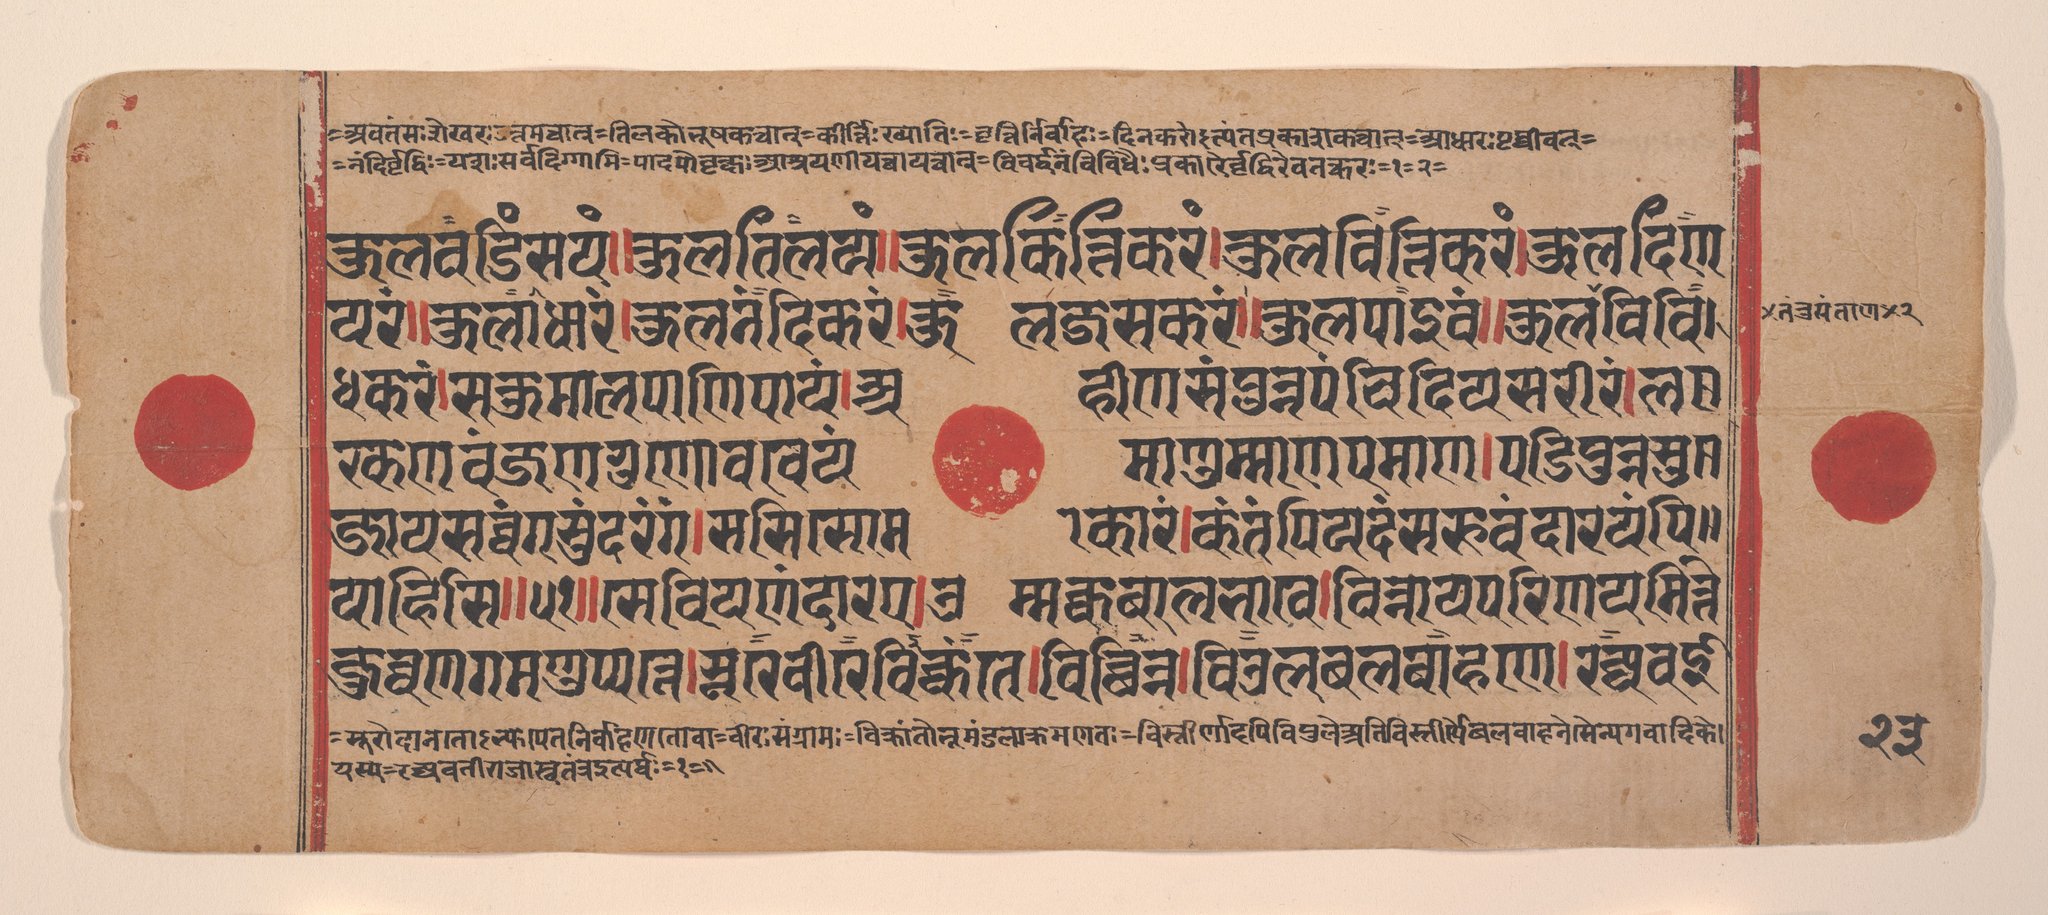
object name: folio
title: Page from a Dispersed Kalpa Sutra (Jain Book of Rituals)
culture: indian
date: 1401-1500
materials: gold, ink, paper, watercolor